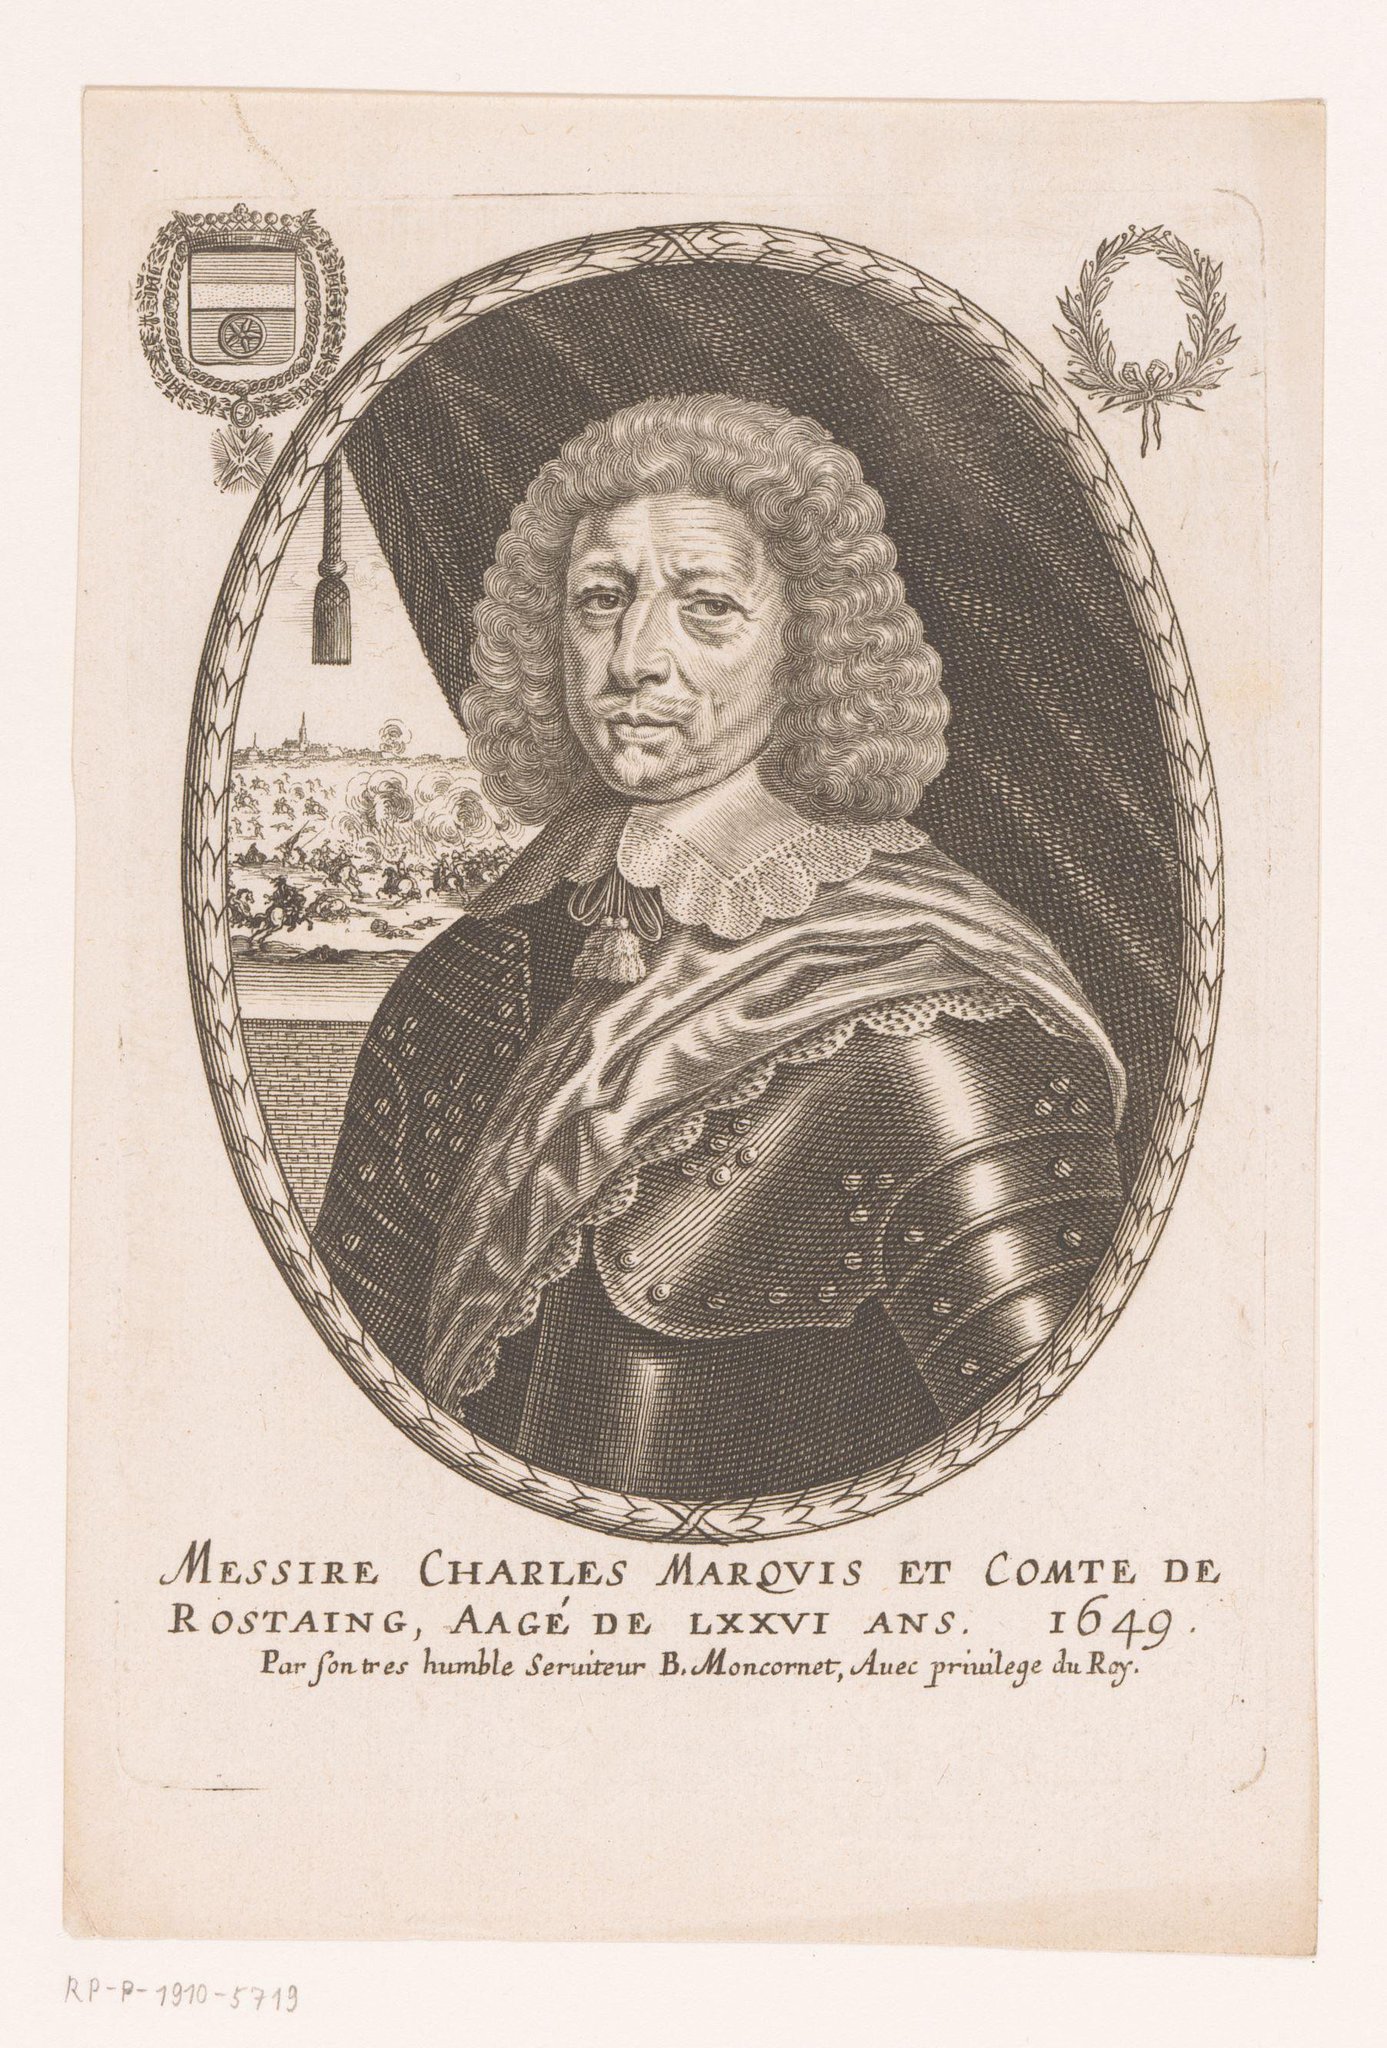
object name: print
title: Portret van Charles, markies en hertog van Rostaing op 76-jarige leeftijd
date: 1649-1668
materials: paper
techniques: engraving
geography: france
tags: earl, historical persons, armorial bearing, heraldry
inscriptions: collector's mark: Lugt 2228